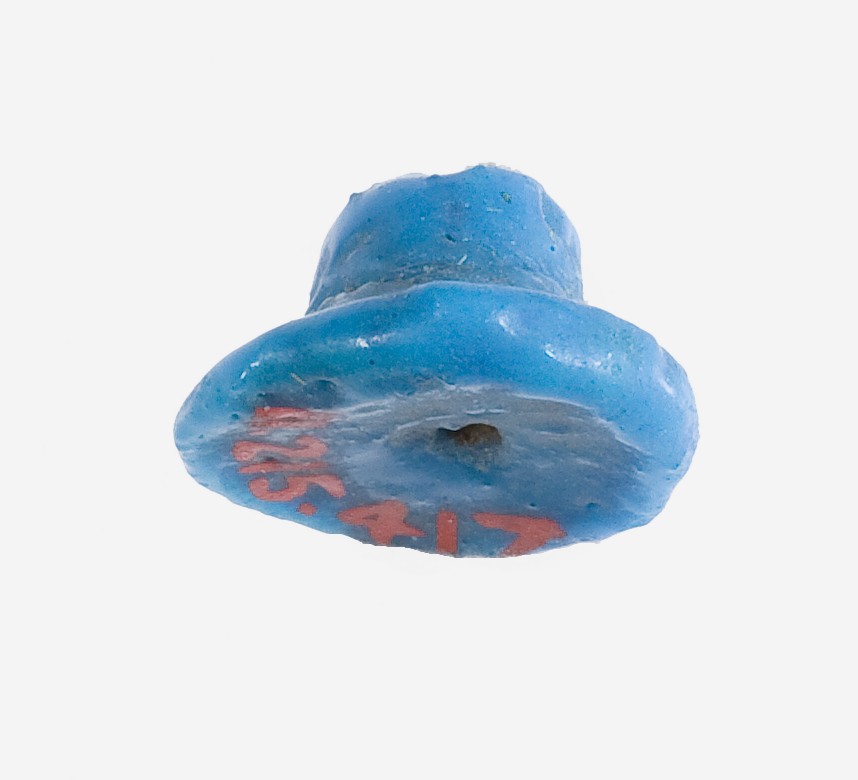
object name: pendant, umbel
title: Umbel Pendant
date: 1390-1352 BCE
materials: faience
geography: egypt